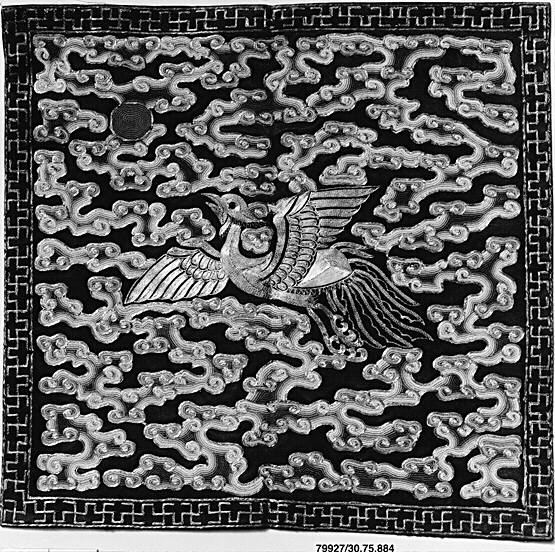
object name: rank badge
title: Rank Badge with Silver Pheasant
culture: chinese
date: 1767-1800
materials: metal thread, silk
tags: pheasants